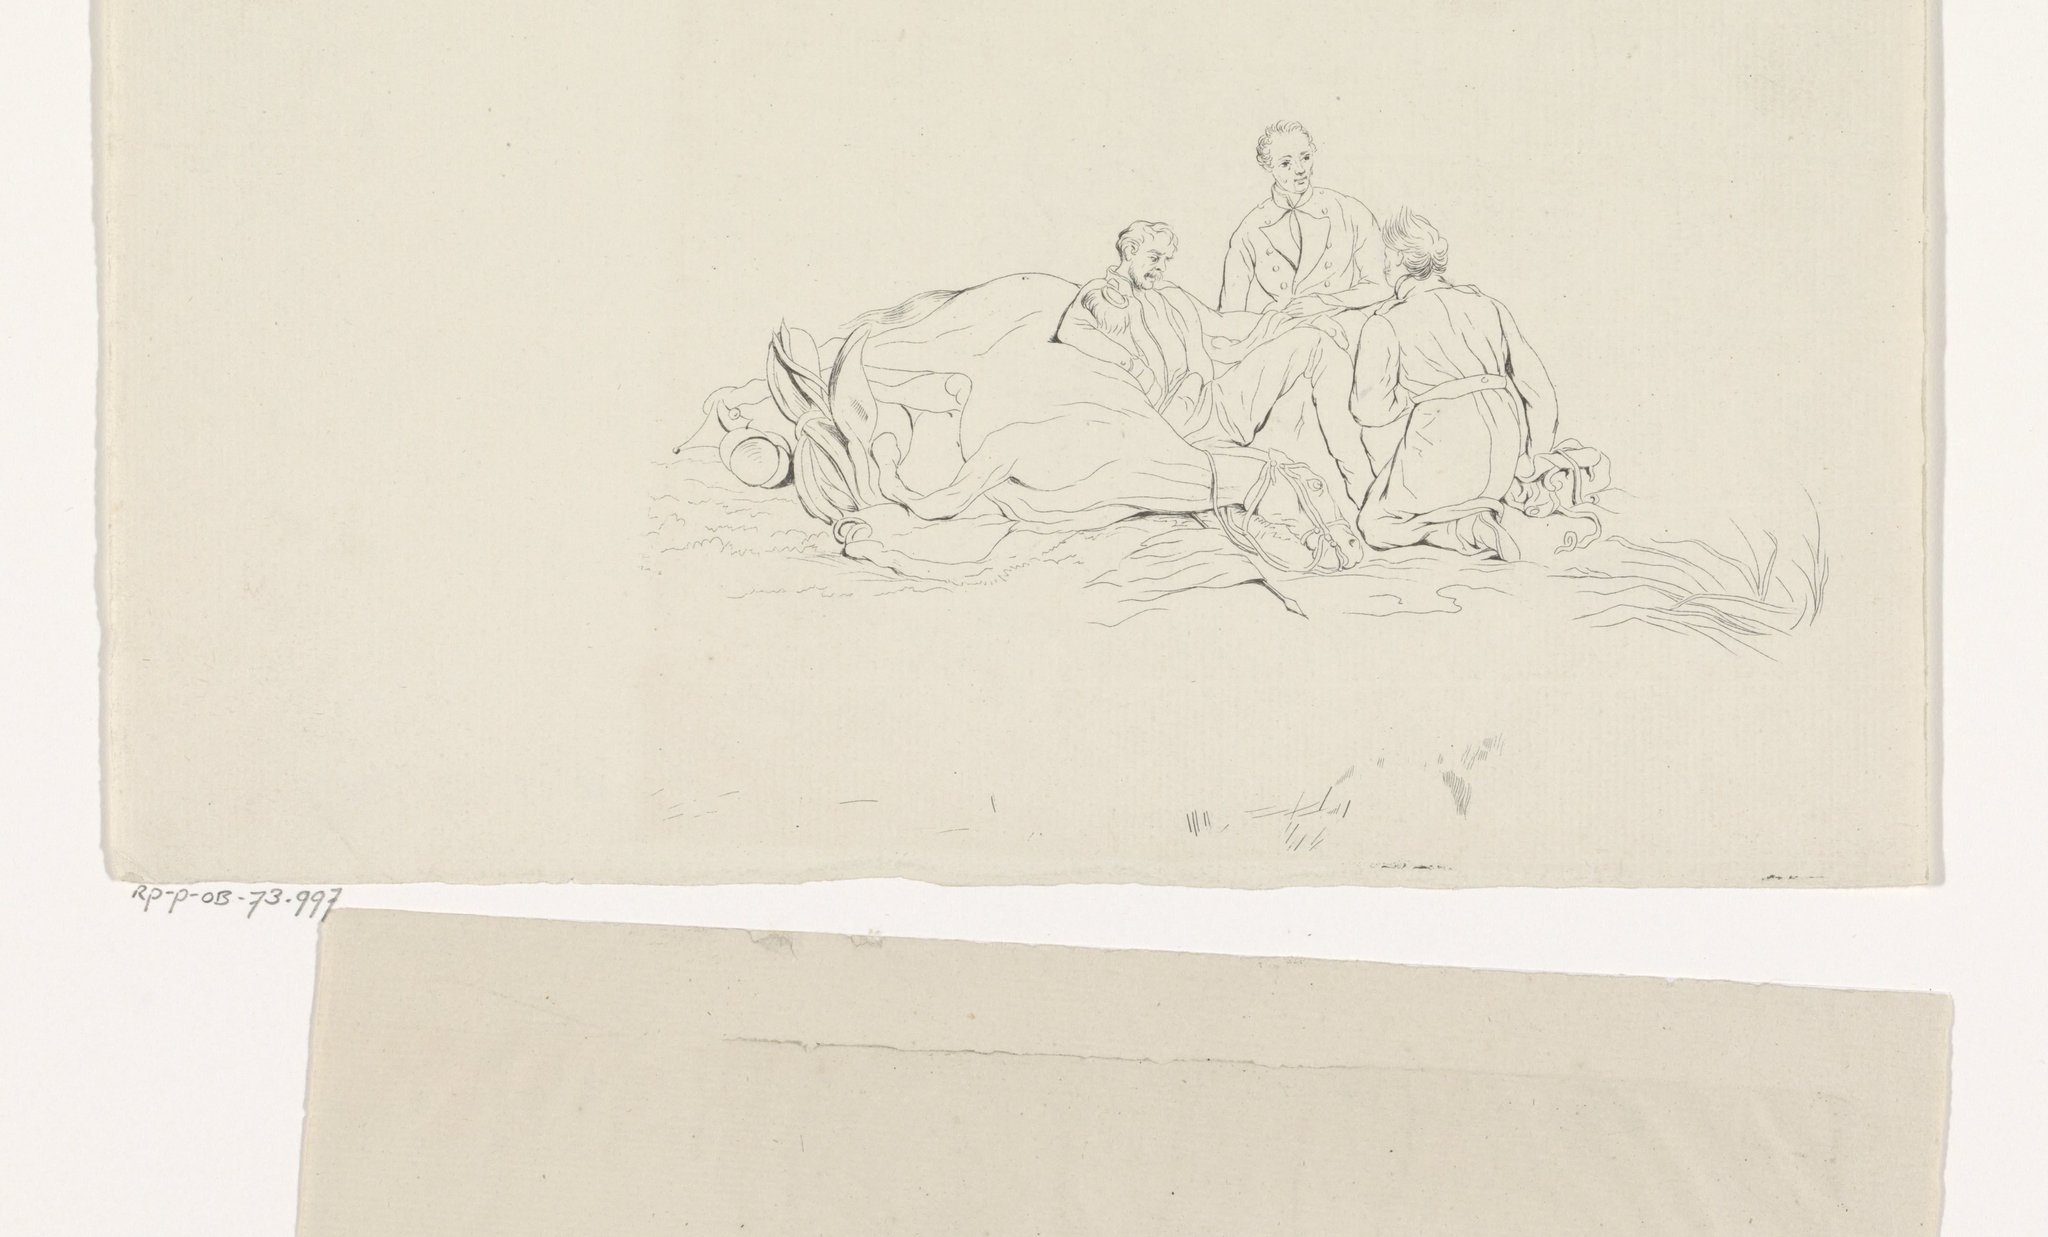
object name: print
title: Drie mannen bij een dood paard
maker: Anonymous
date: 1800-1850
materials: paper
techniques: etching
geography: netherlands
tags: medical aid and nursing of the sick and wounded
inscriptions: collector's mark: Lugt 2228